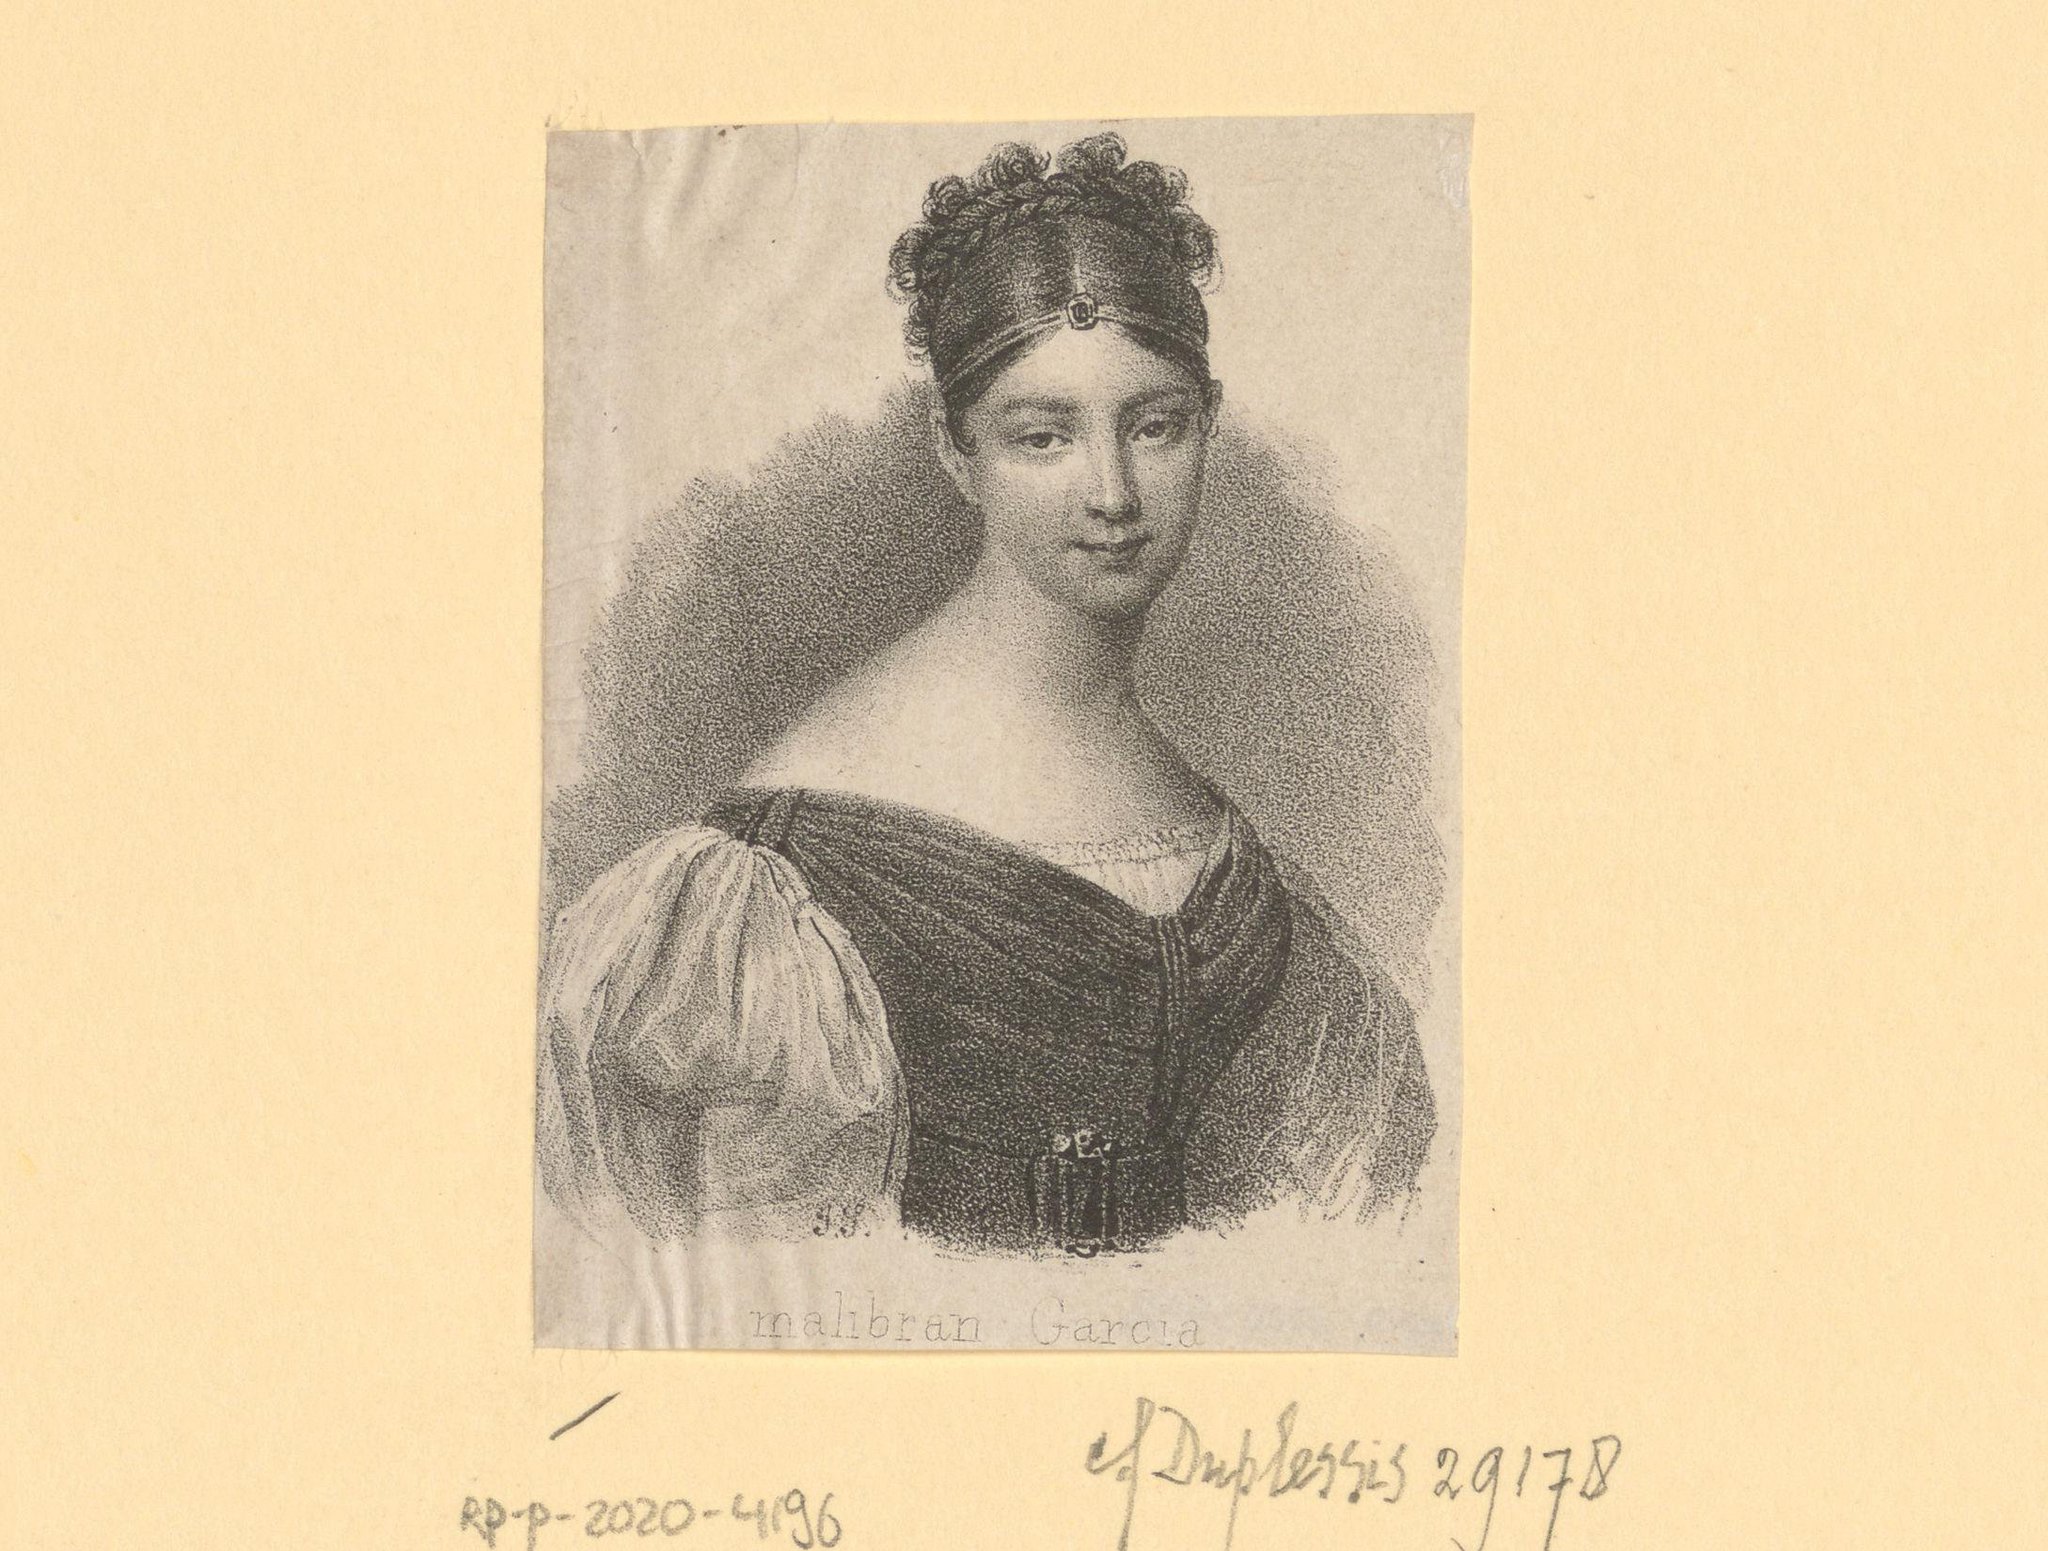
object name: print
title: Portret van Maria Malibran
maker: j.j.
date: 1818-1836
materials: paper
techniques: lithograph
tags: historical persons, portrait of opera-singer